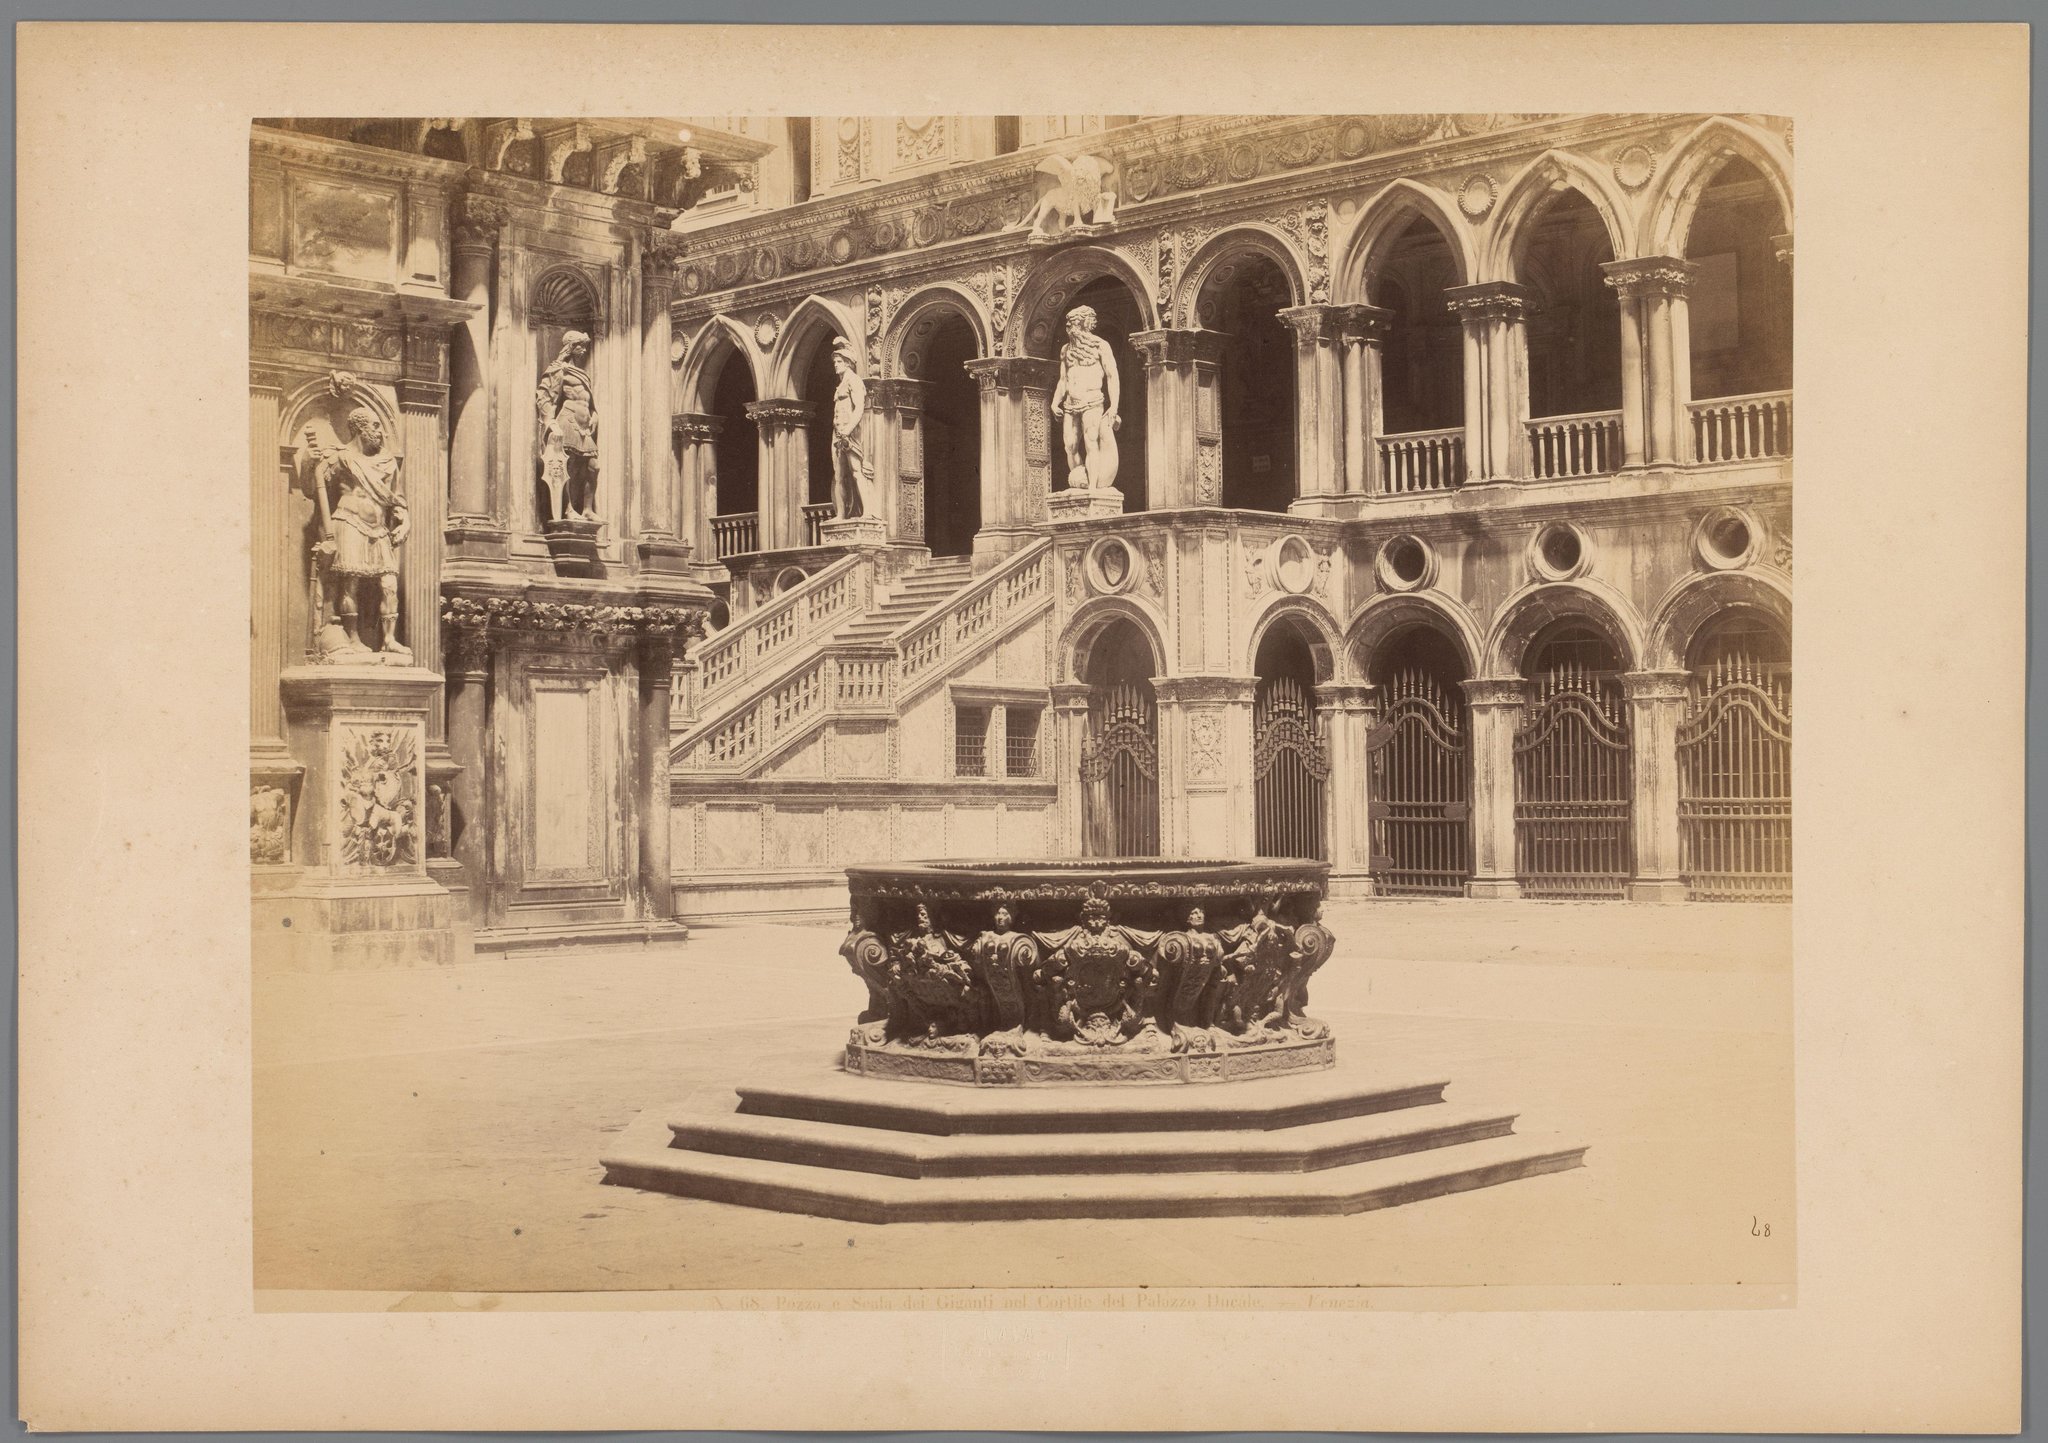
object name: photograph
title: Binnenplaats van het Dogepaleis met de Scala dei Giganti te Venetië, Italië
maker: carlo naya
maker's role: fotograaf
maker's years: 1816-1882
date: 1857-1882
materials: cardboard, paper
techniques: albumen print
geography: venice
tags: inner court of palace or 'hôtel'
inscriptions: inscription: ‘No. 68 VENEZIA./ Pozzo nel Cortile del Palazzo Ducale./ Puits en bronze dans la cour du Palais Ducal, coulé par/ ALberghetti (1559). (...)’, number: ‘87’, number: ‘No. 68.’